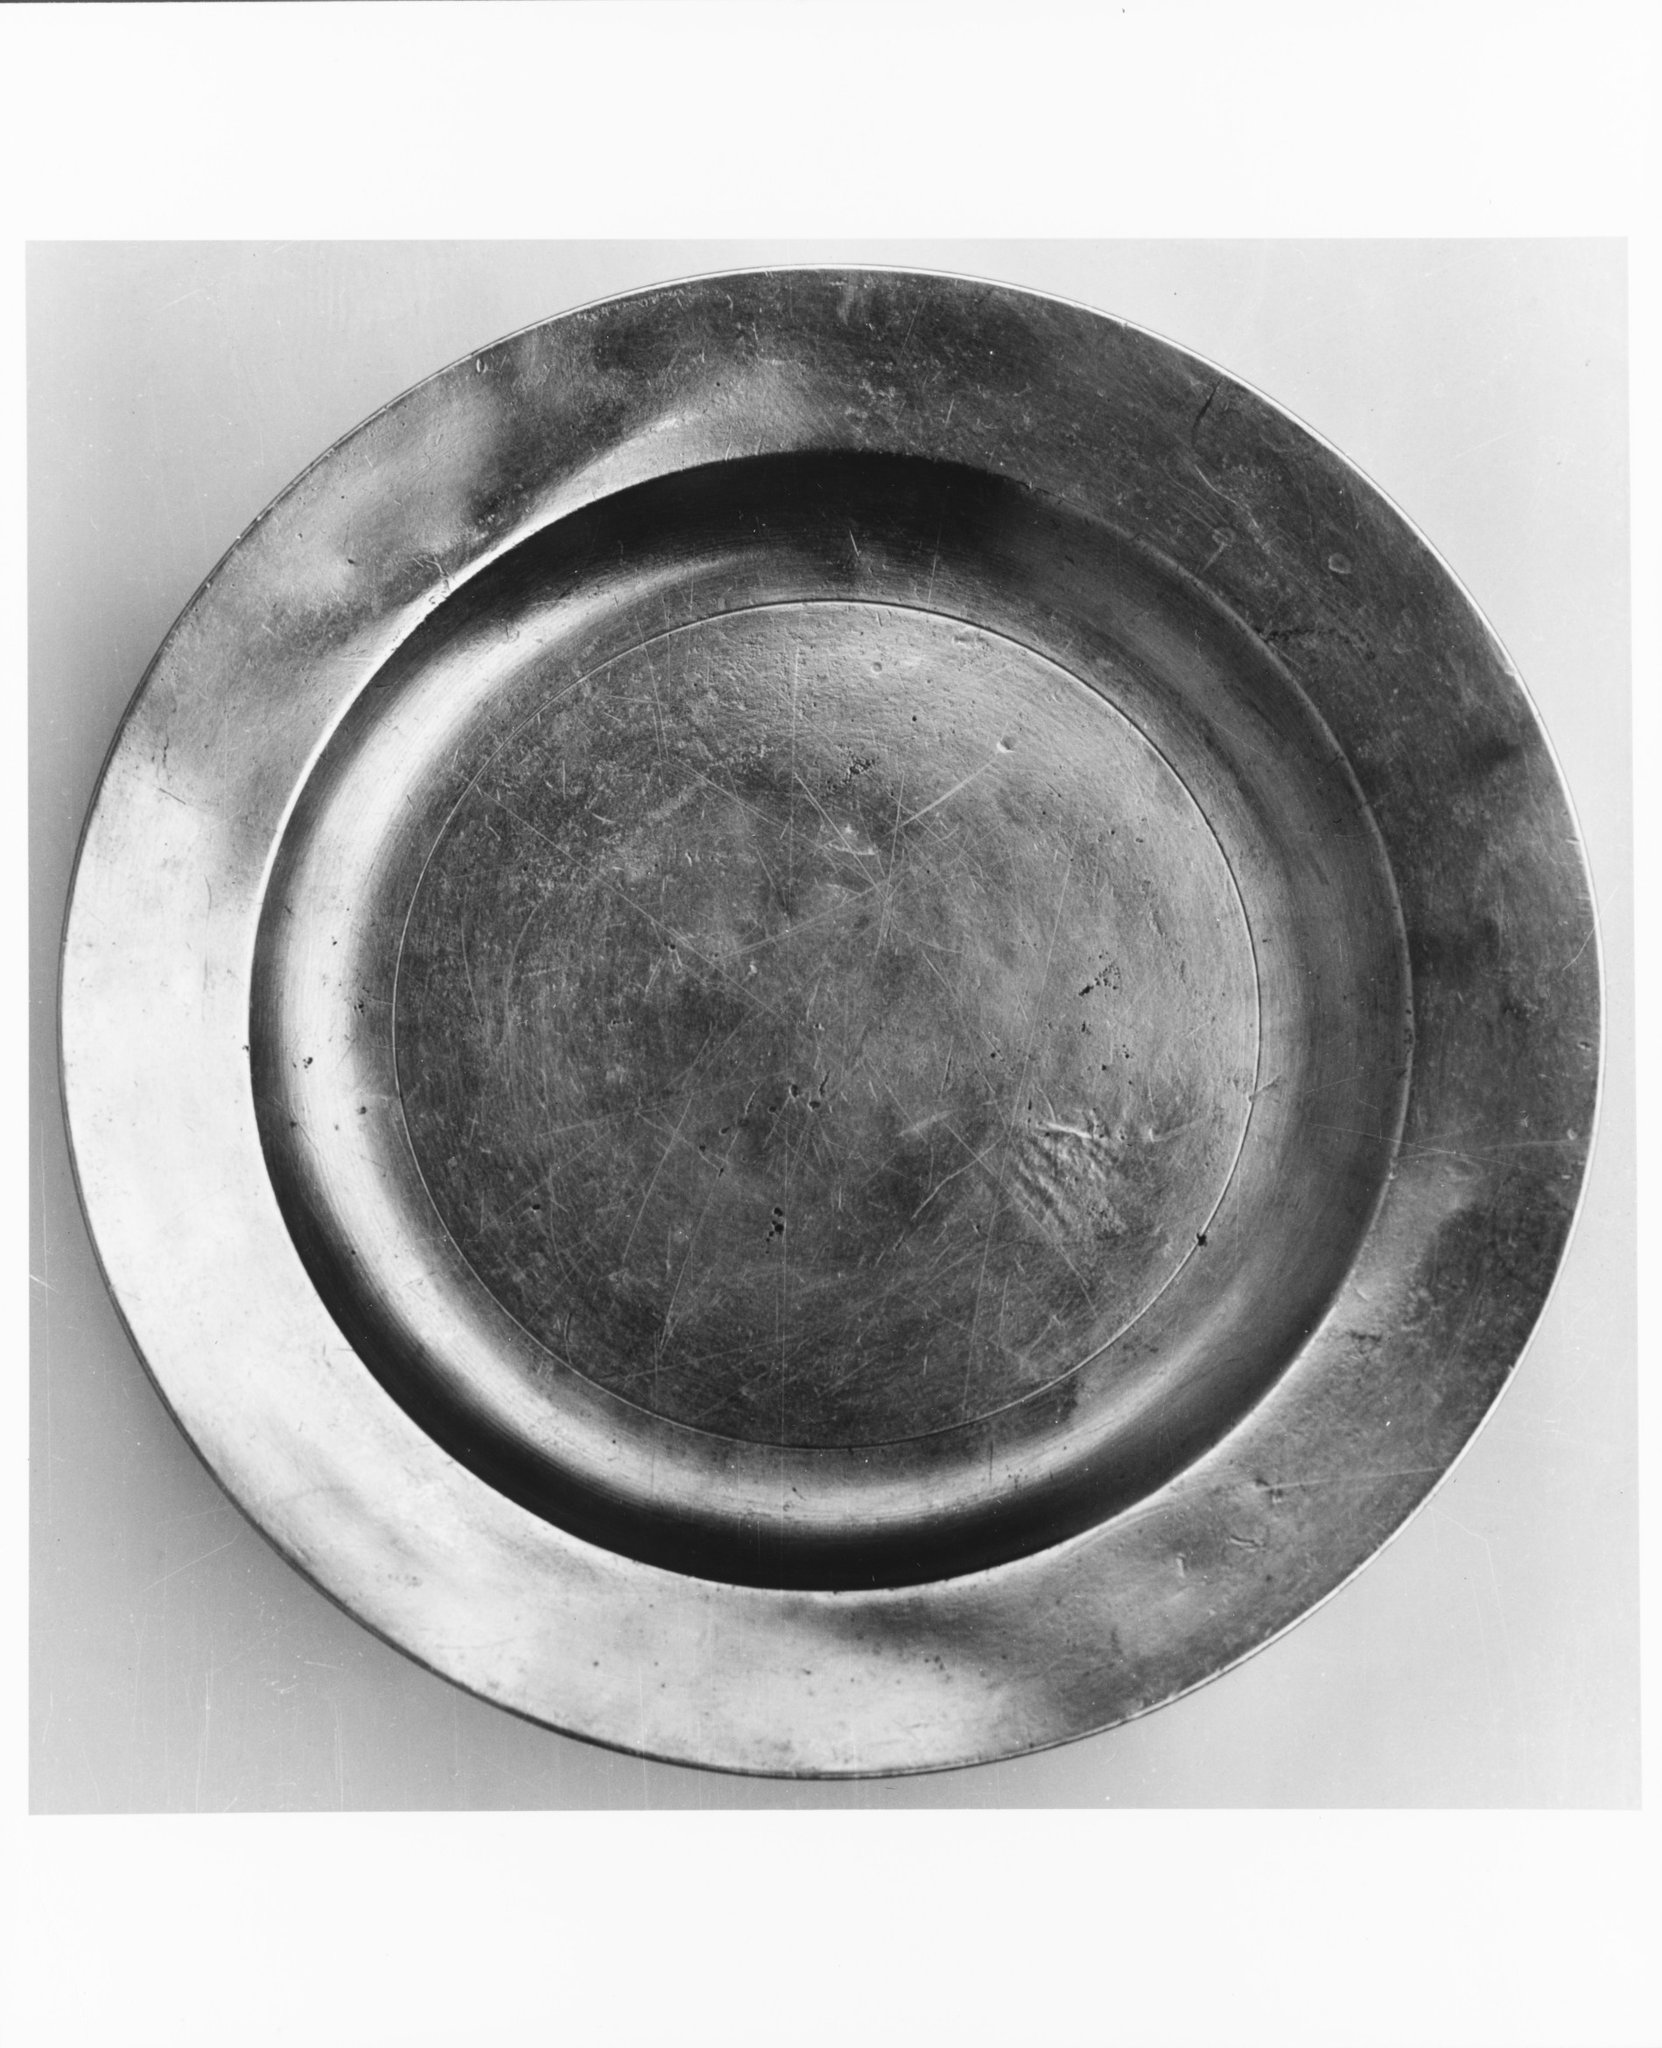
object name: plate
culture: american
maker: frederick bassett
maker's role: maker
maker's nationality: american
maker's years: 1740-1800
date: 1761-1799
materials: pewter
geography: united states